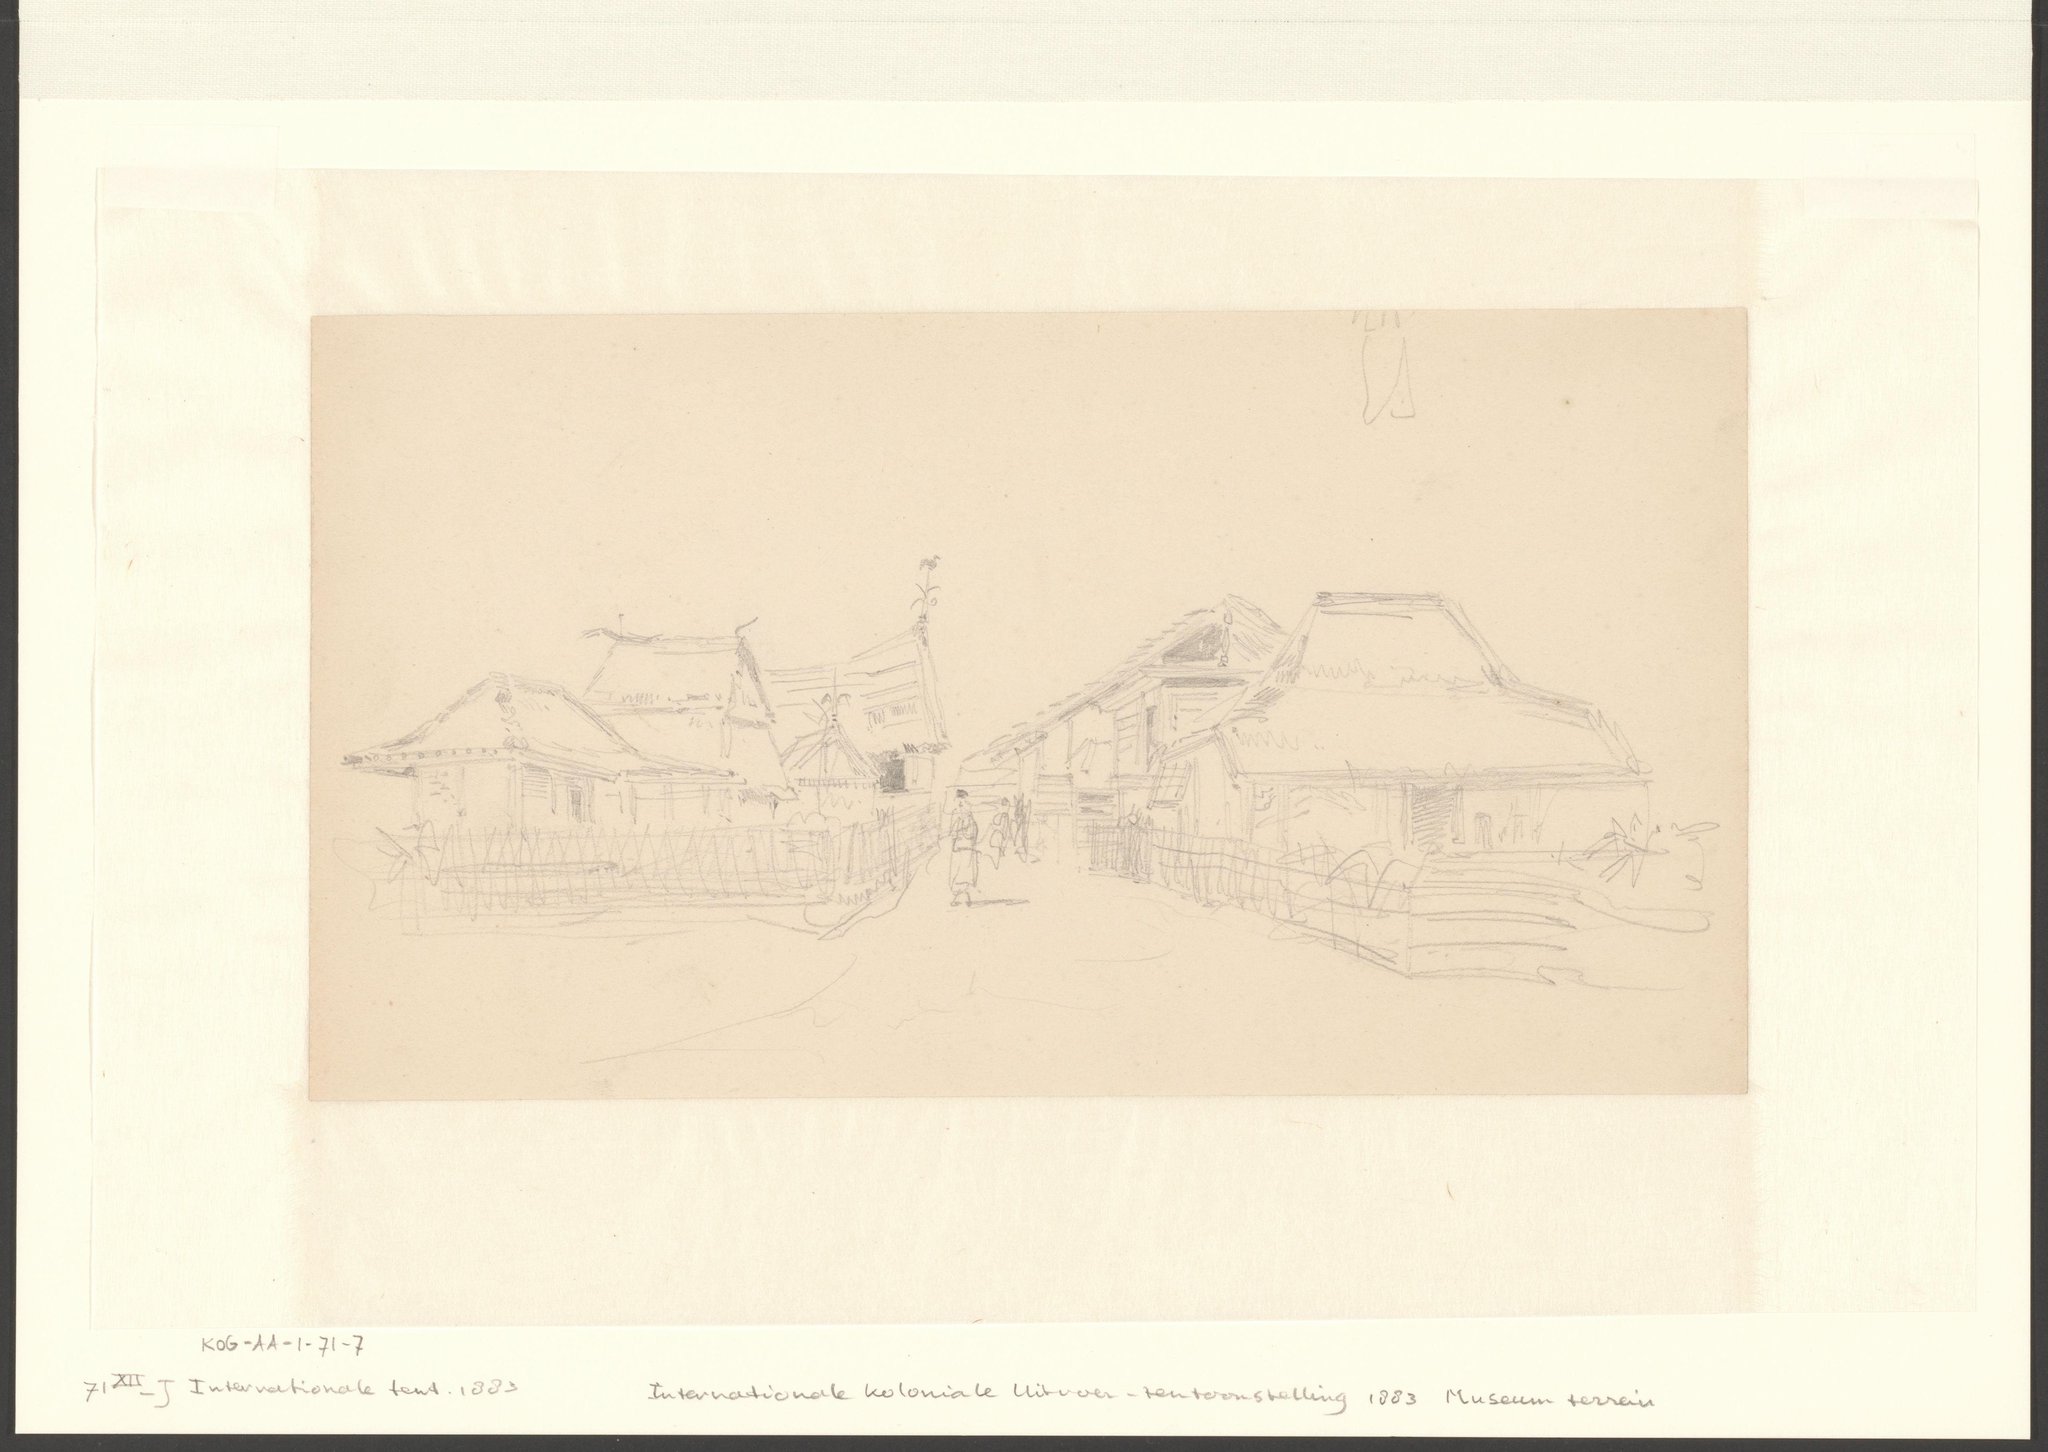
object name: drawing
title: Interieur van de Koloniale Afdeling op de Internationale Koloniale en Uitvoerhandel Tentoonstelling te Amsterdam van 1883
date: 1883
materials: paper, pencil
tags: trade exhibition, industries fair, city-view in general; 'veduta', world fair, world exhibition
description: Onderwerpsrubriek binnen de Atlas Amsterdam: Tentoonstellingen (chronologisch).